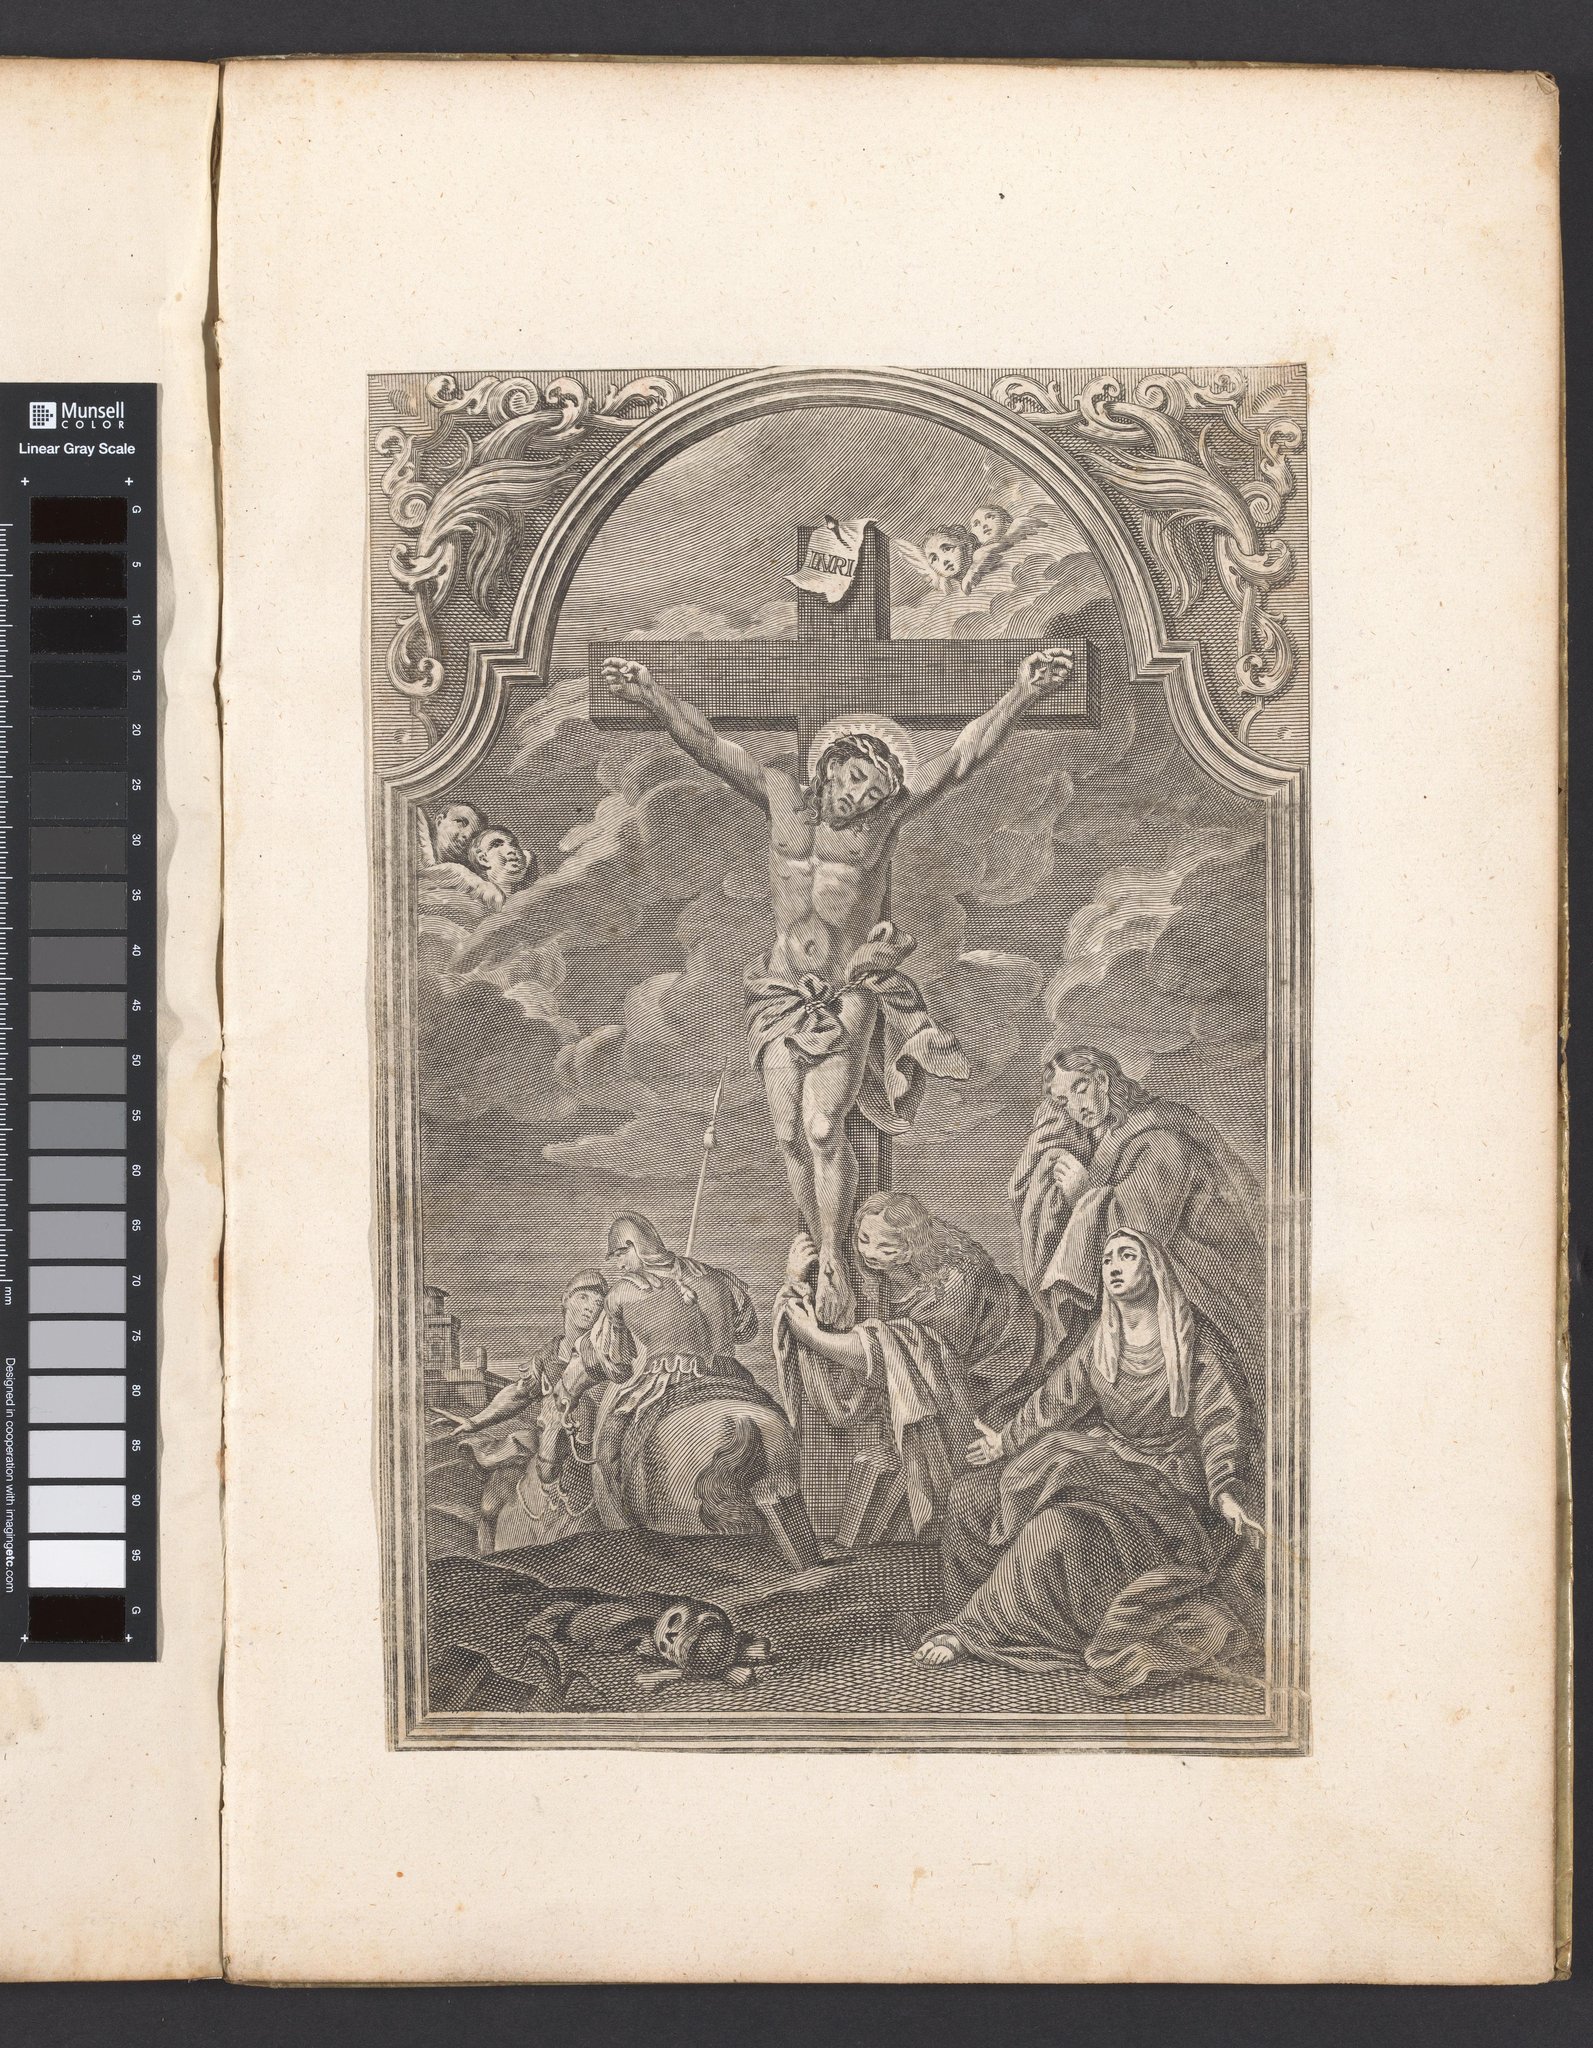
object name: print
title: Kruisiging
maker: Anonymous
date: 1600-1699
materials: paper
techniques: engraving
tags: crucified christ, with particular persons under the cross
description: Deze prent maakt deel uit van een album.